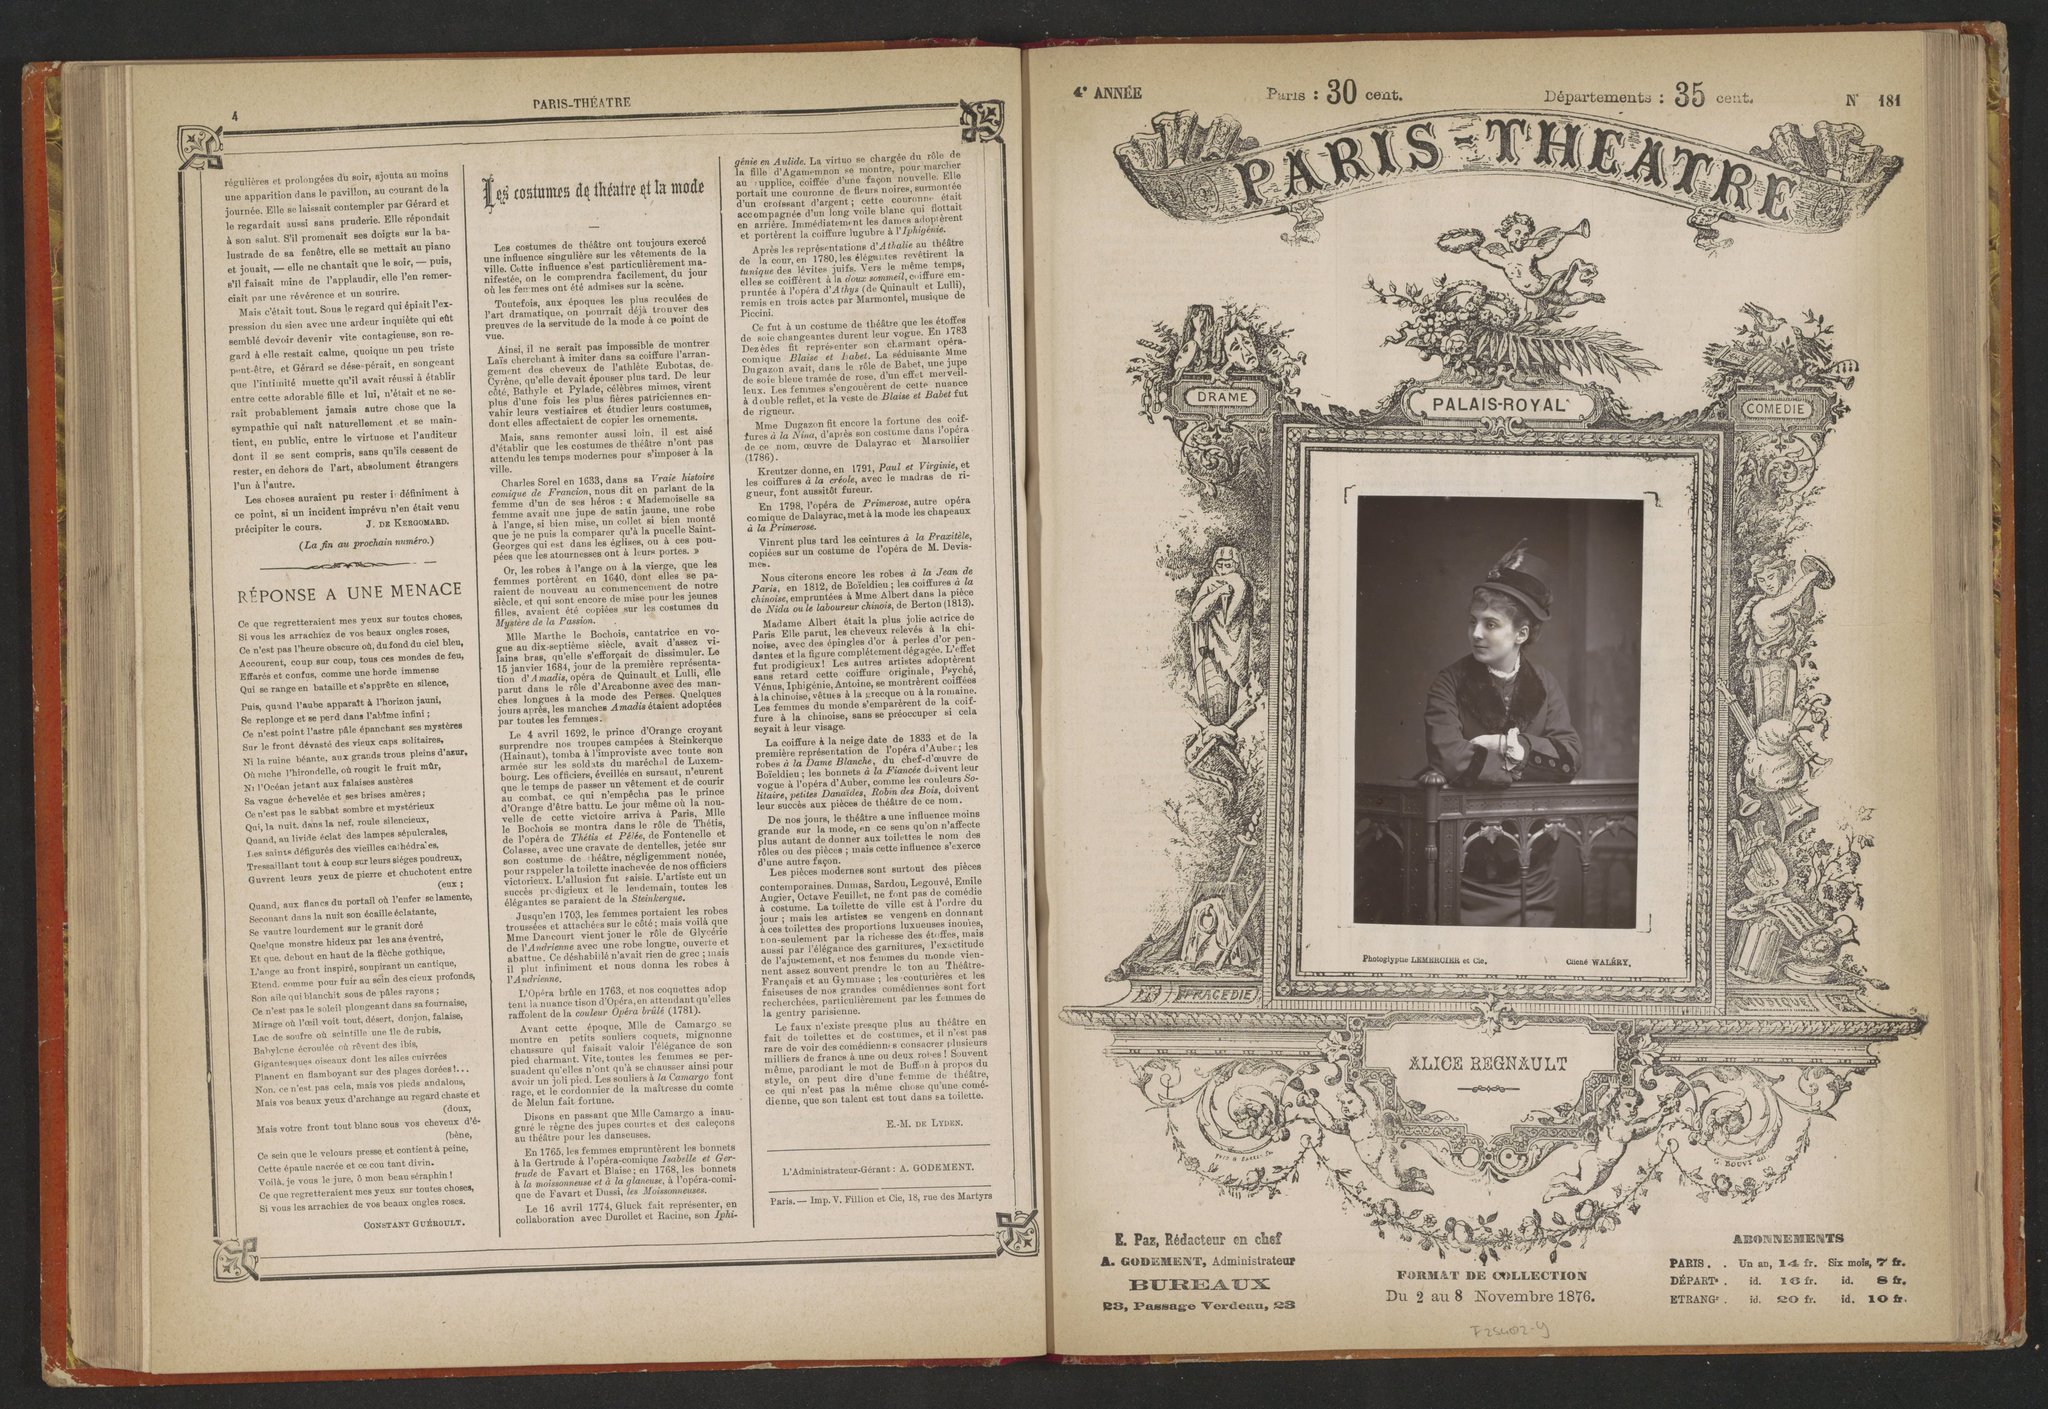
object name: photomechanical print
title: Portret van Alice Regnault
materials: paper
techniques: woodburytype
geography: paris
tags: portrait of actor, actress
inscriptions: inscription: ‘Du 2 au 8 Novembre 1876.’, number: ‘N' 181’